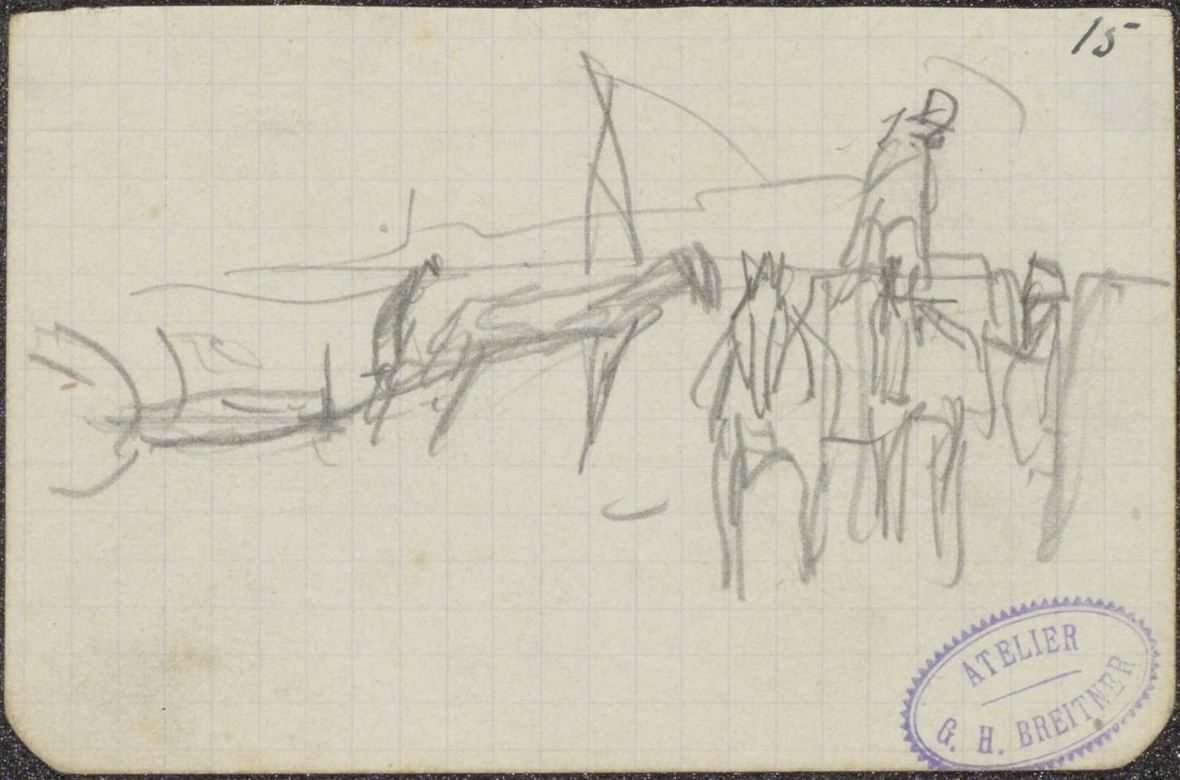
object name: drawing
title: Rijtuig en sleperskar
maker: george hendrik breitner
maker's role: draughtsman, painter, print maker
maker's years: 1857-1923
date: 1890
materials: pencil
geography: amsterdam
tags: four-wheeled, animal-drawn vehicle, e.g.: cab, carriage, coach, horse, (farm) wagon, freight wagon, cart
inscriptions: annotation: ‘terug uit Breda.’, collector's mark: Lugt 2228, workshop stamp: Lugt 291d